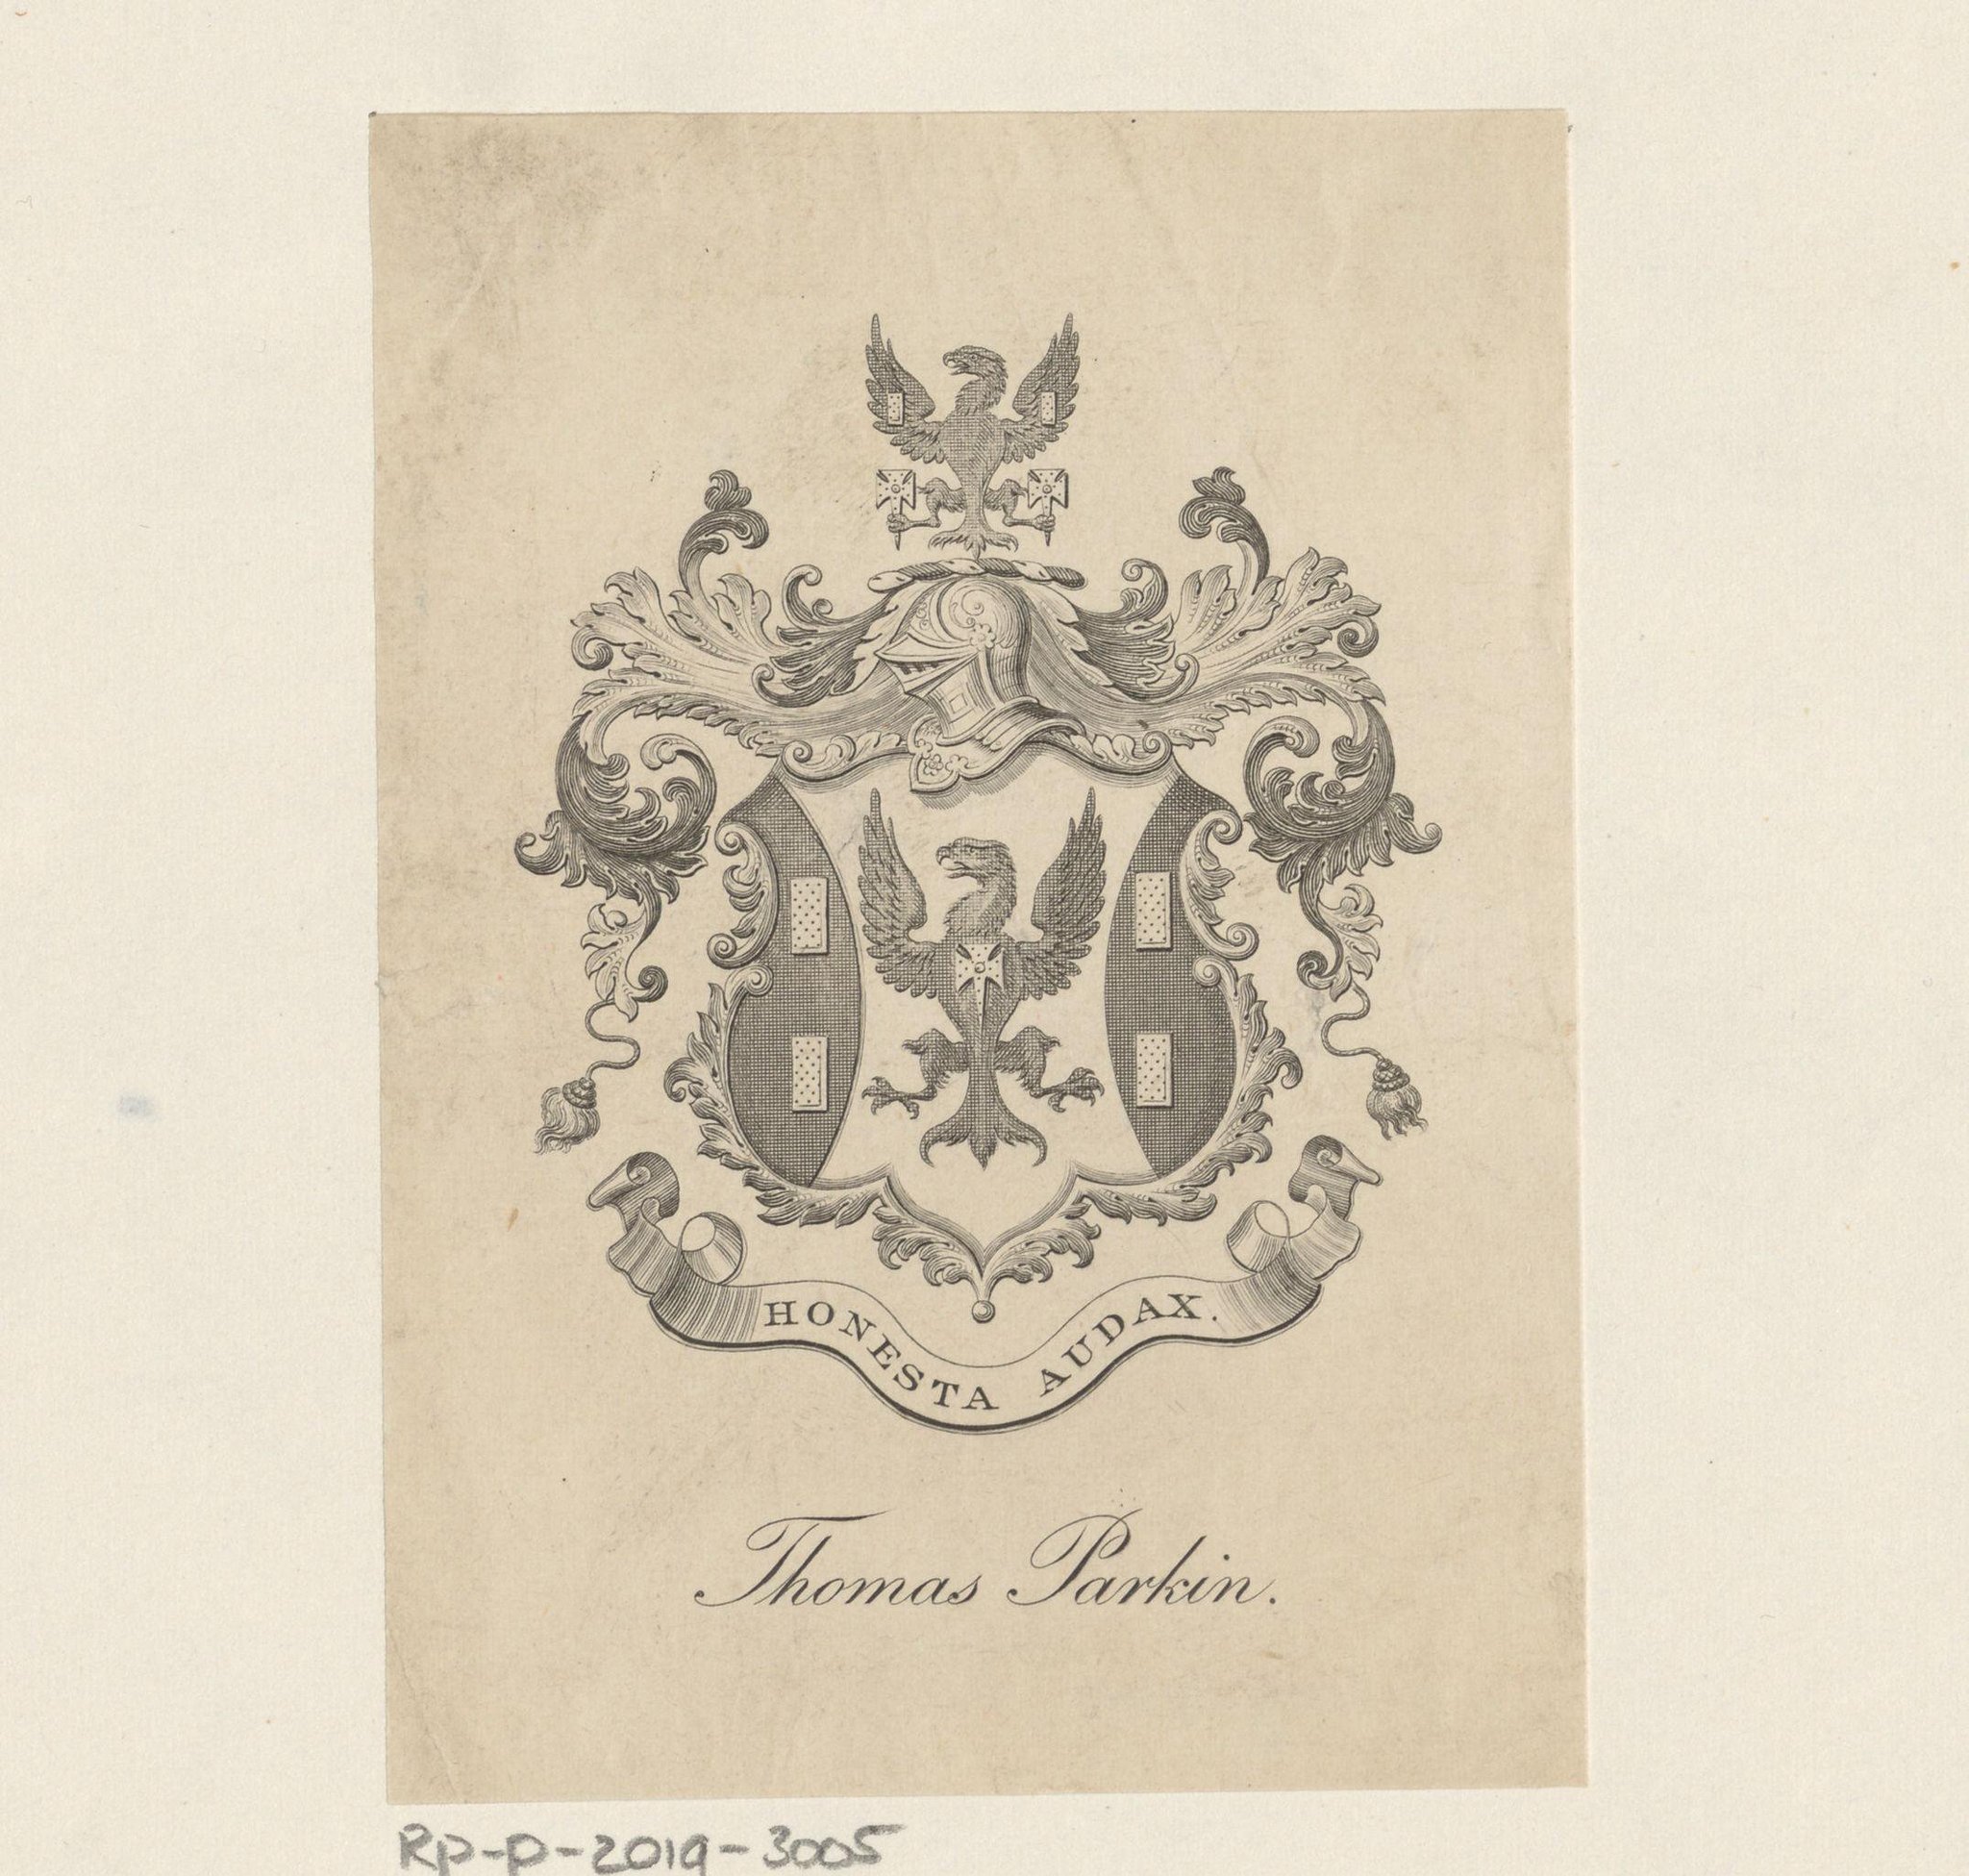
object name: bookplate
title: Honesta audax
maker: Anonymous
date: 1850-1899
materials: paper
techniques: engraving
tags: armorial bearing, heraldry